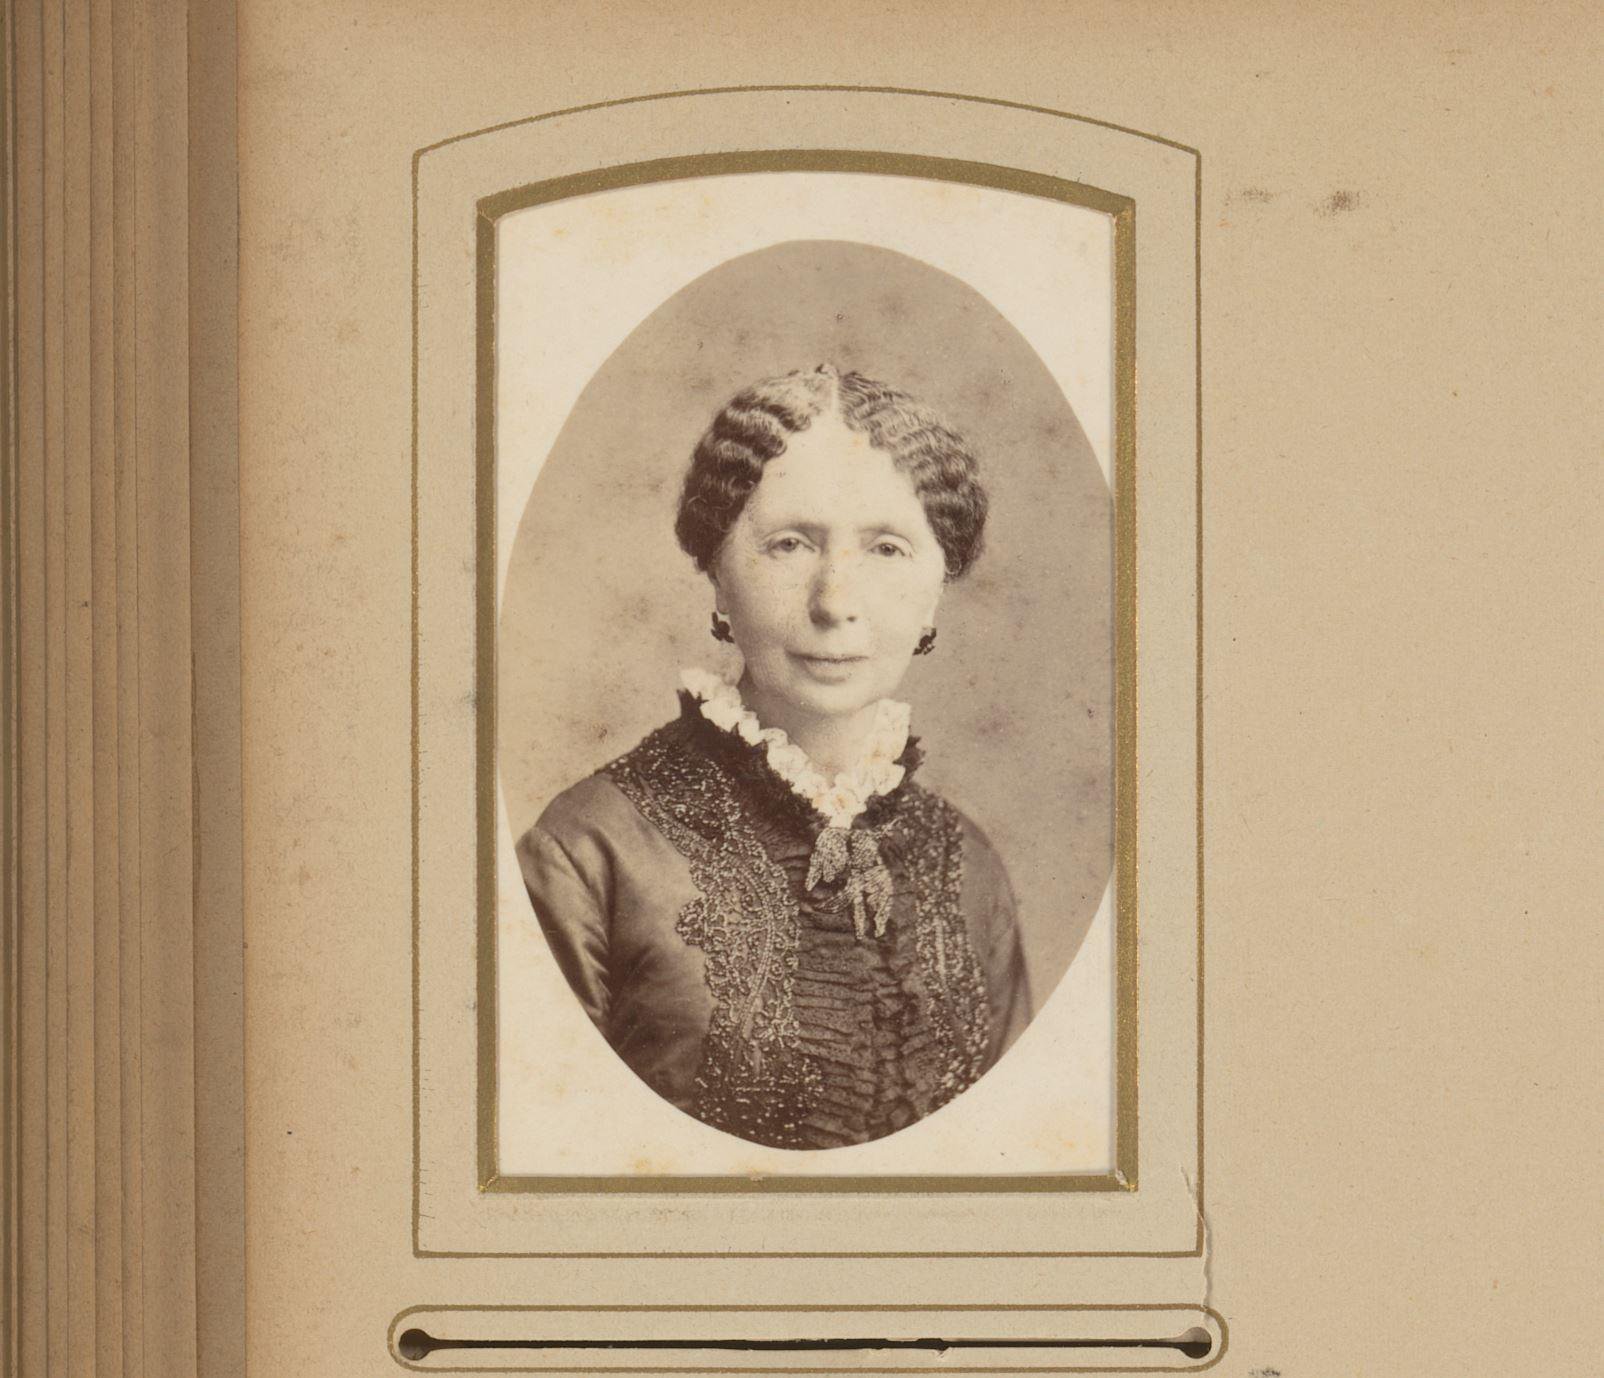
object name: carte de visite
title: Portret van een vrouw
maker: théodor weijnen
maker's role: fotograaf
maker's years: 1835-1904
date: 1865-1883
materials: cardboard, photographic support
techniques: albumen print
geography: maastricht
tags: historical persons - bb - woman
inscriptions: inscription: ‘No.../ Photographie/ Theod. Weynen/ Rue du Caque 1776./ Maestricht/ Les clichés sont conservés.’